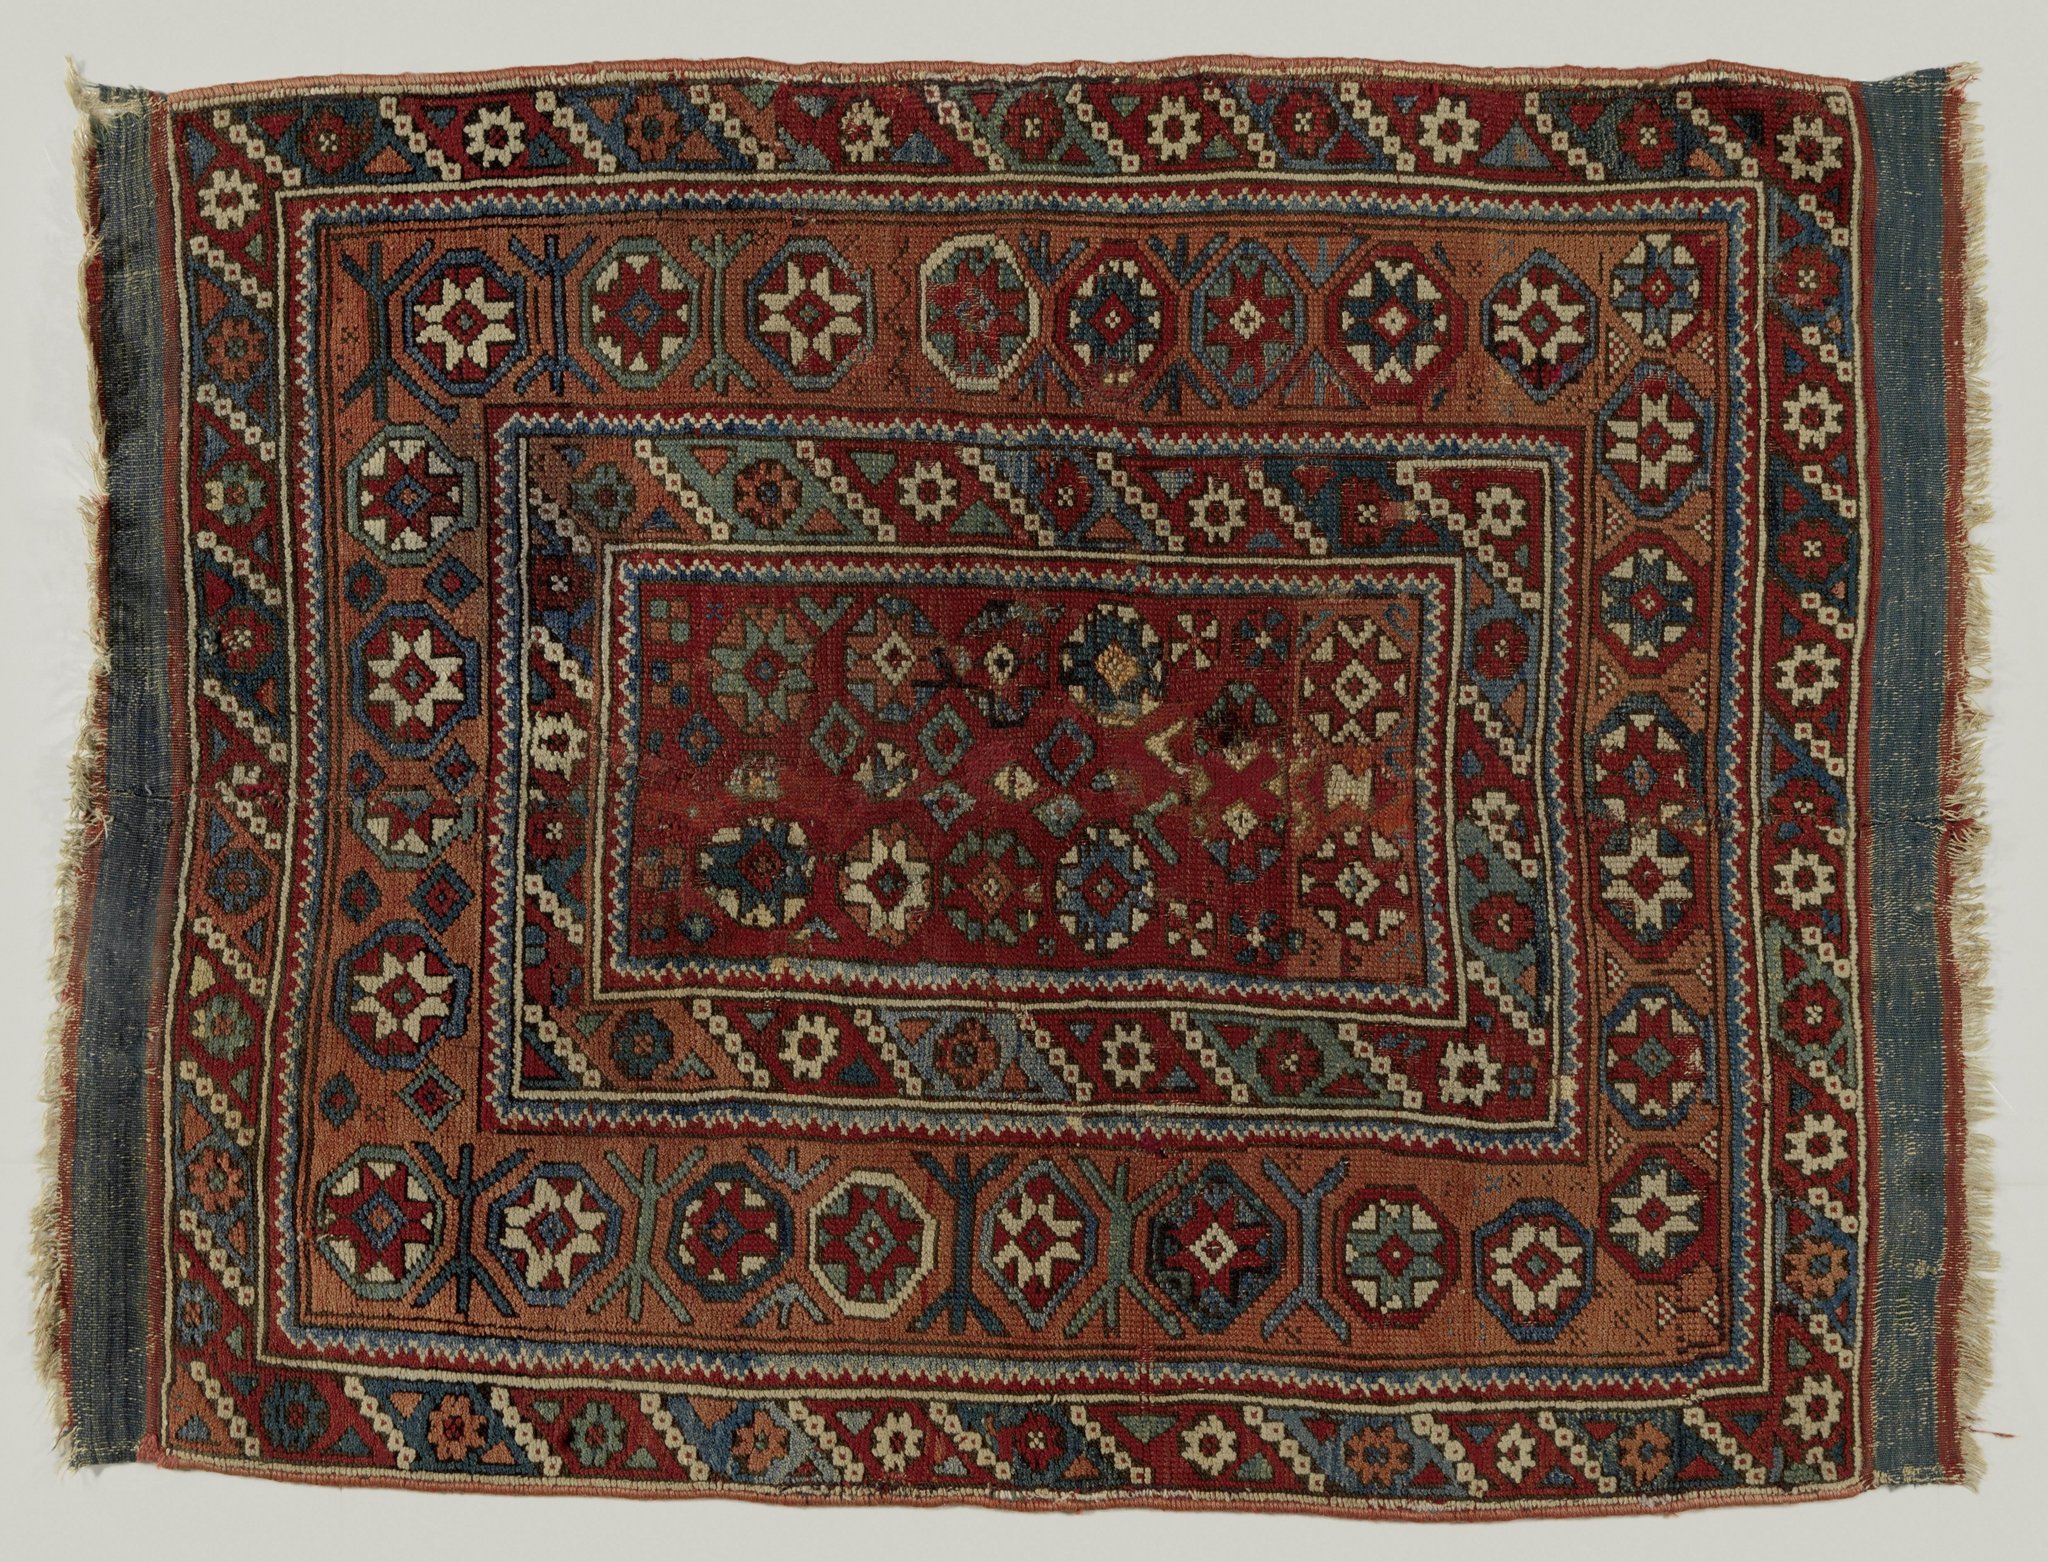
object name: oriental rug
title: Bloemenkleed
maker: Anonymous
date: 1840-1860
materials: wool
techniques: ghiordes knot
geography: eastern asia minor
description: Bloemenkleed. Middenveld: op een klein donkerrood veld staan sterbloemen in een dubbele baan. Om elke sterbloem een achthoekje in wit, rood, lichtgroen en blauw. Randen: breed en drievoudig. De hoofdrand is in oranje met dergelijke sterbloemen in achthoekenk. De binnen- en buitenzomen zijn gelijk, met bruinzwarte fond waarop schuin gerekt ruiten in blauw, rood en groen, onderbroken door schuine rijtjes witte blokken. Baard: zowel onder- als bovenaan loopt een brede baard resp. van 8 en 7 cm, in blauw met enkele strepen in rood.